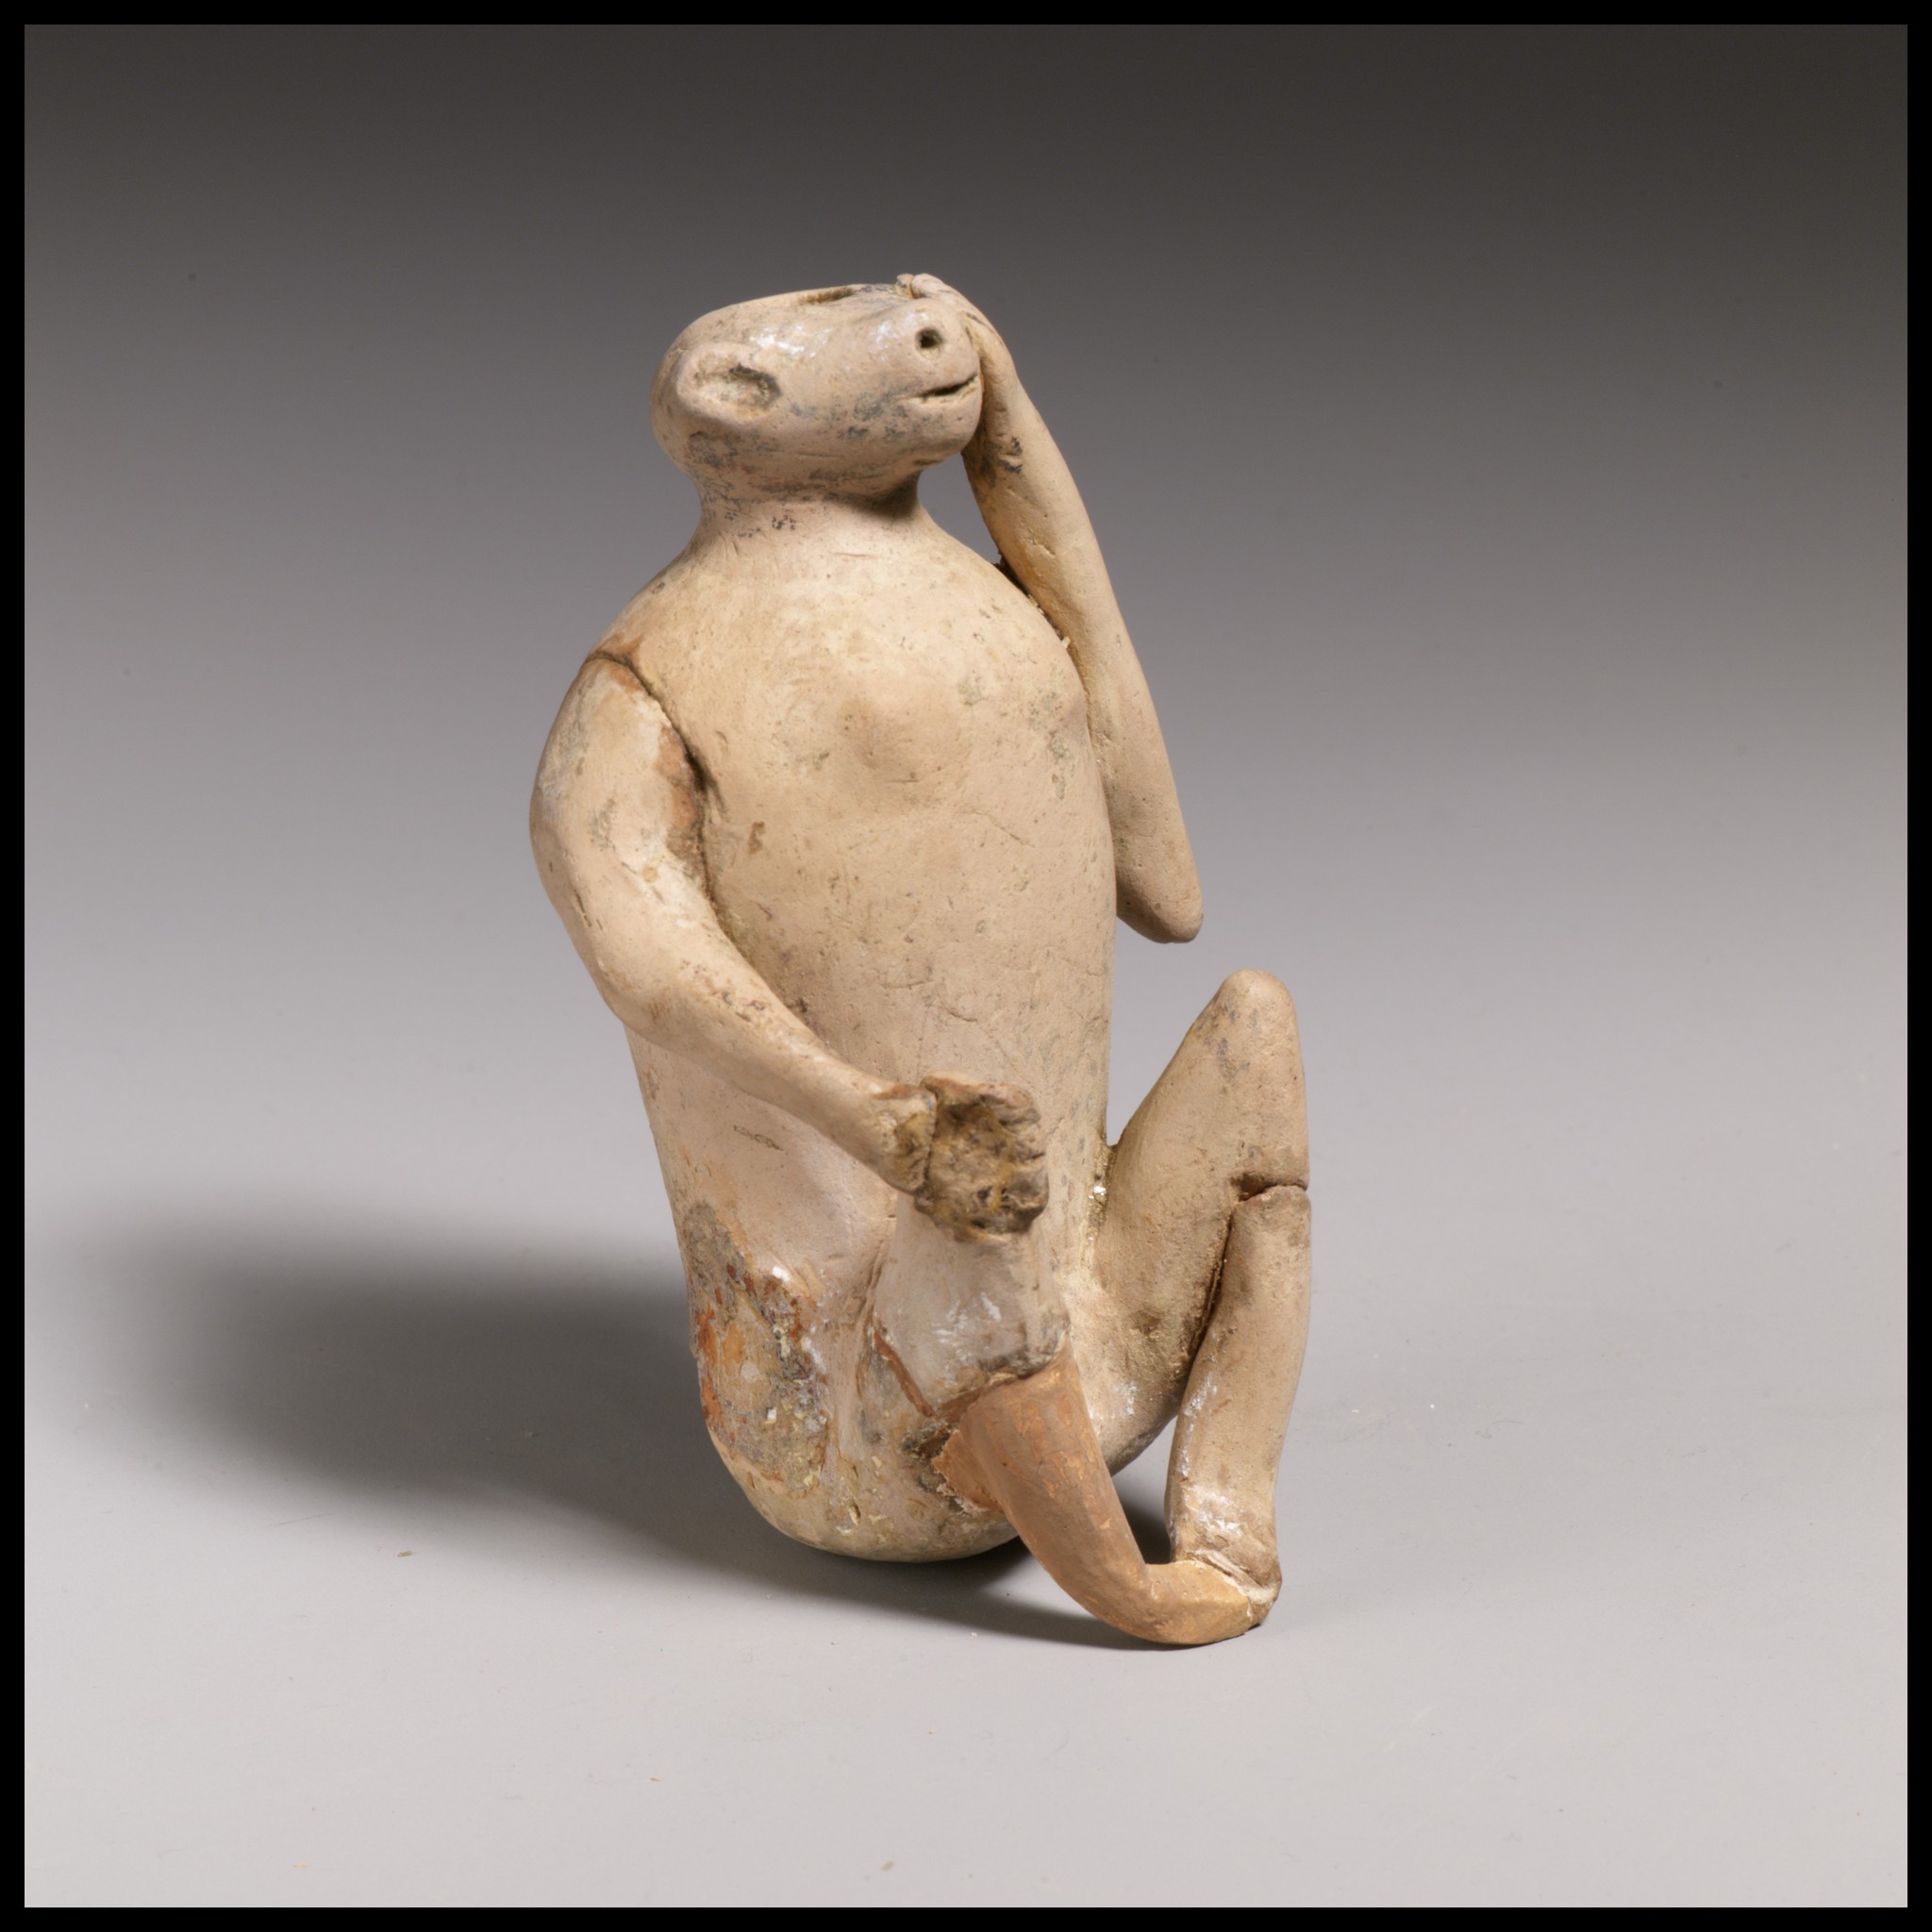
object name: vase, monkey, baby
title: Terracotta vase in the form of an ape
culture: etruscan or greek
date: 400-301 BCE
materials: terracotta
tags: apes